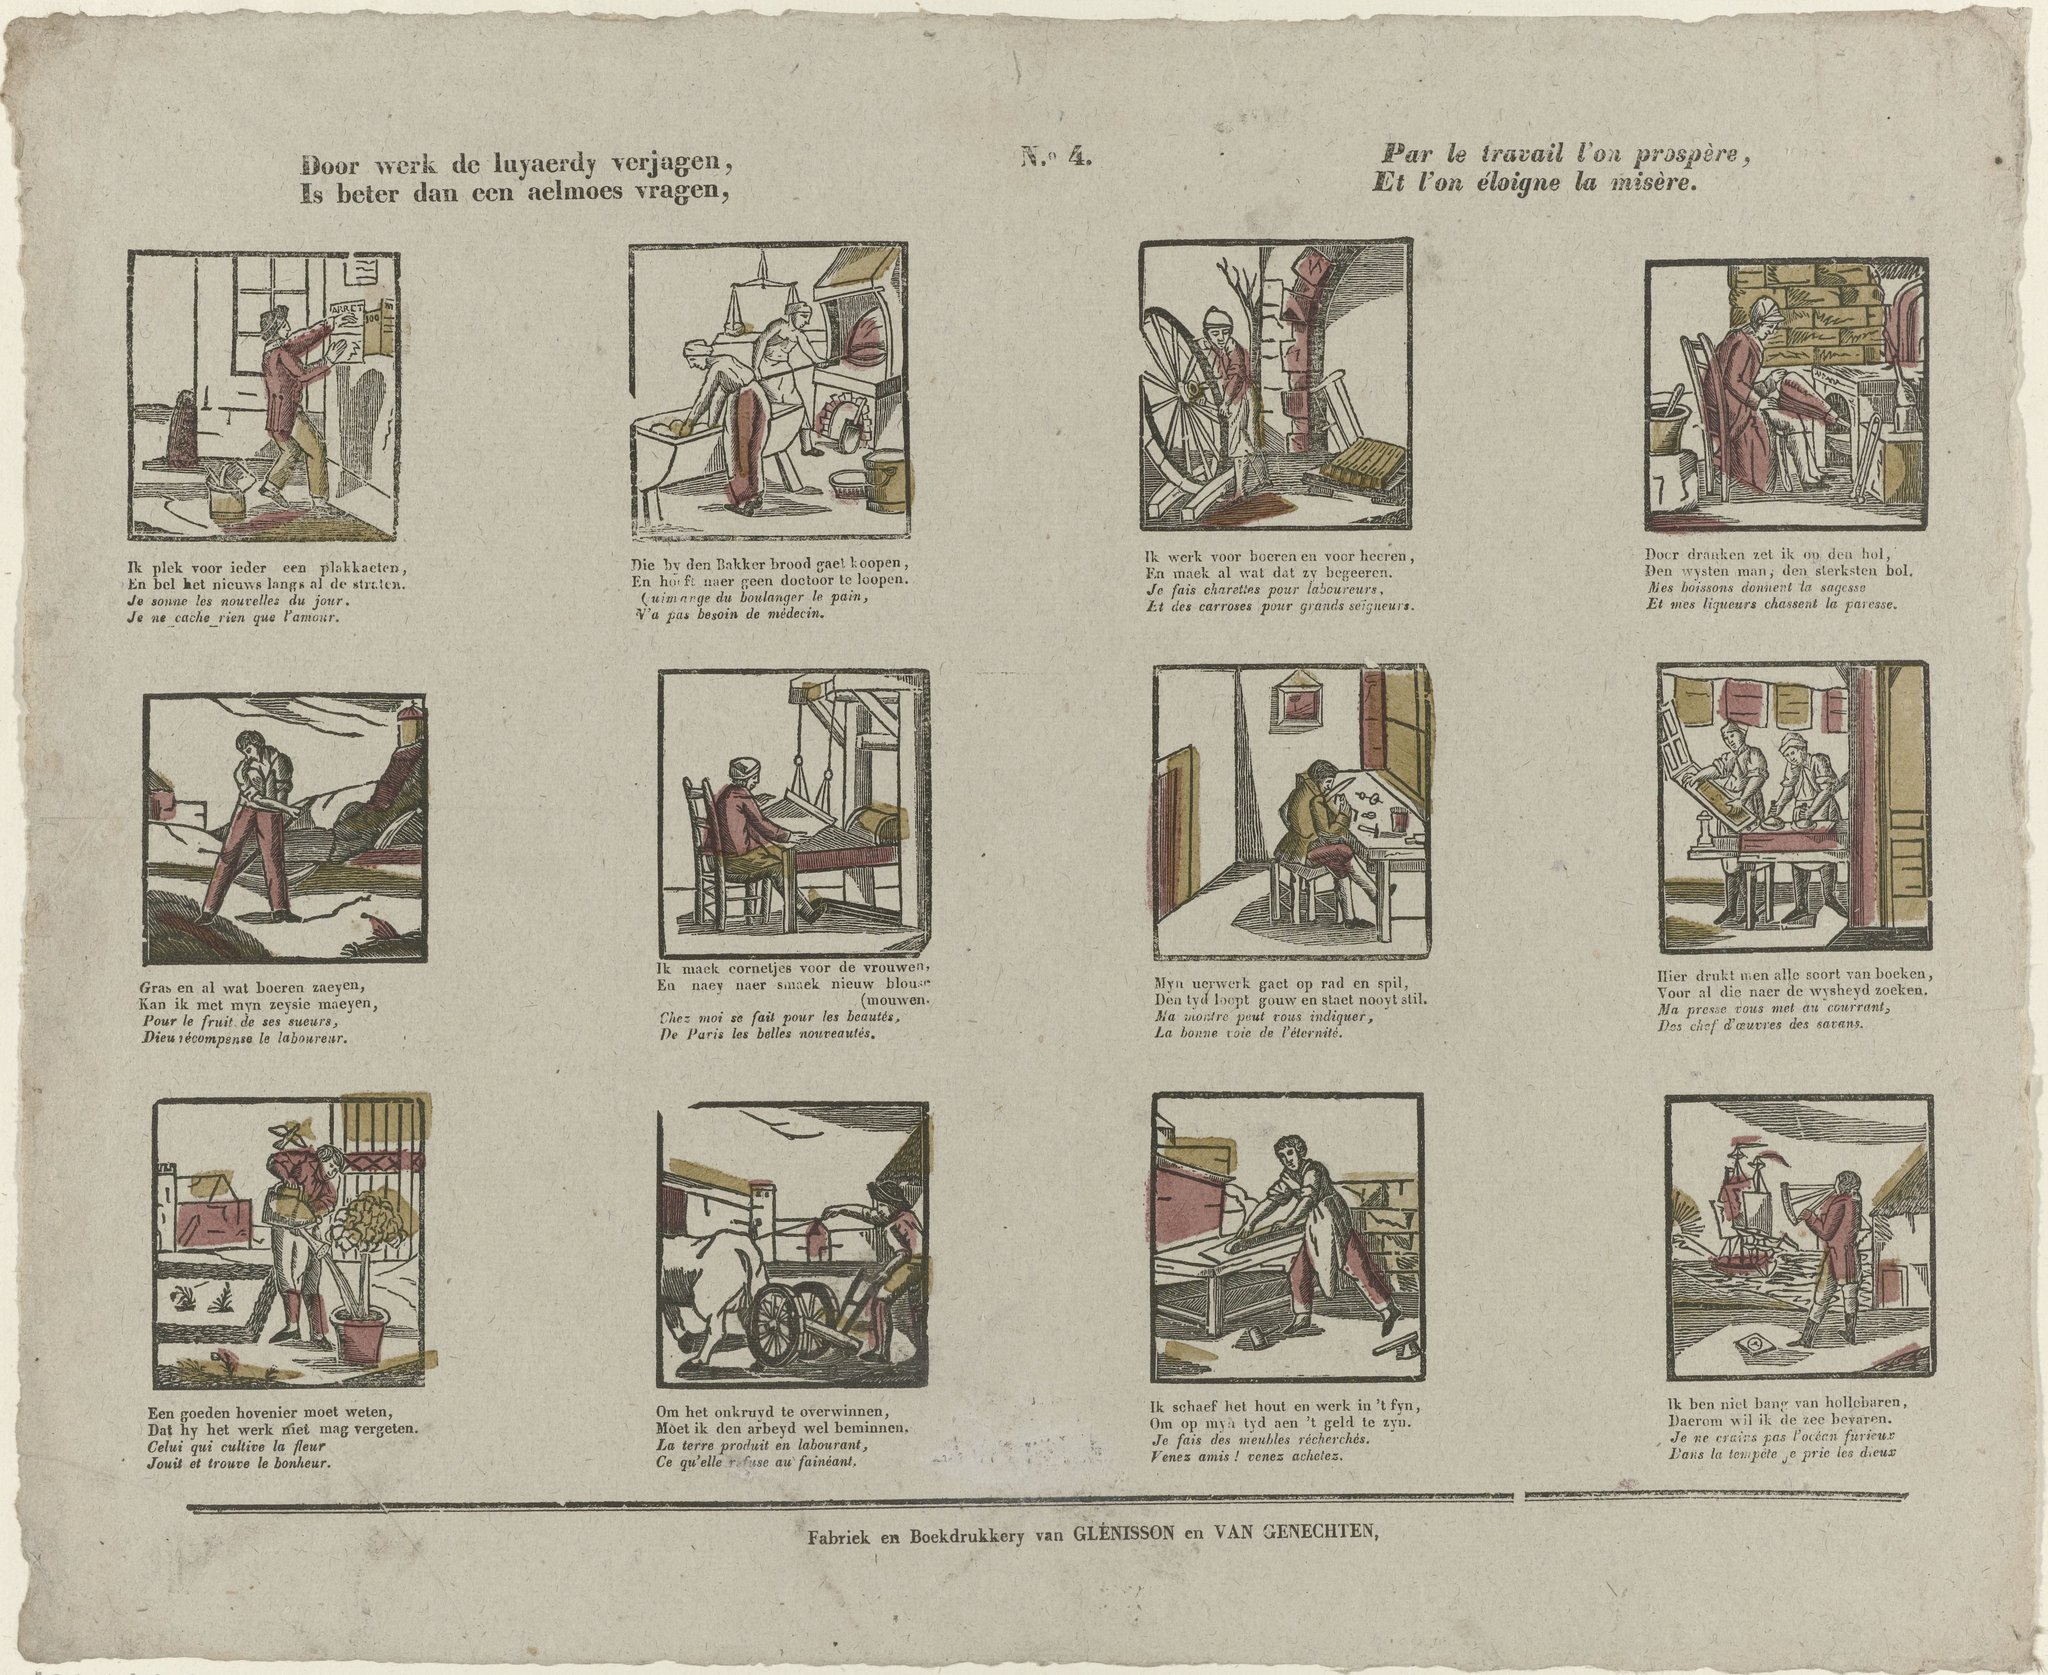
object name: popular print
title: Door werk de luyaerdy verjagen, / Is beter dan een aelmoes vragen, / Par le travail l'on prospère, / Et l'on é loigne la misère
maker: Anonymous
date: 1833-1856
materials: paper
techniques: colour, letterpress printing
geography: turnhout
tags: craft-production, skilled handiwork, baker, printer, crafts and industries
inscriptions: collector's mark: Lugt 2760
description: Blad met 12 voorstellingen van ambachtslieden en beroepen, zoals bakker, horlogemaker en boekdrukker. Onder elke afbeelding een tweeregelig vers in het Nederlands en in het Frans. Genummerd midden boven: No. 4.